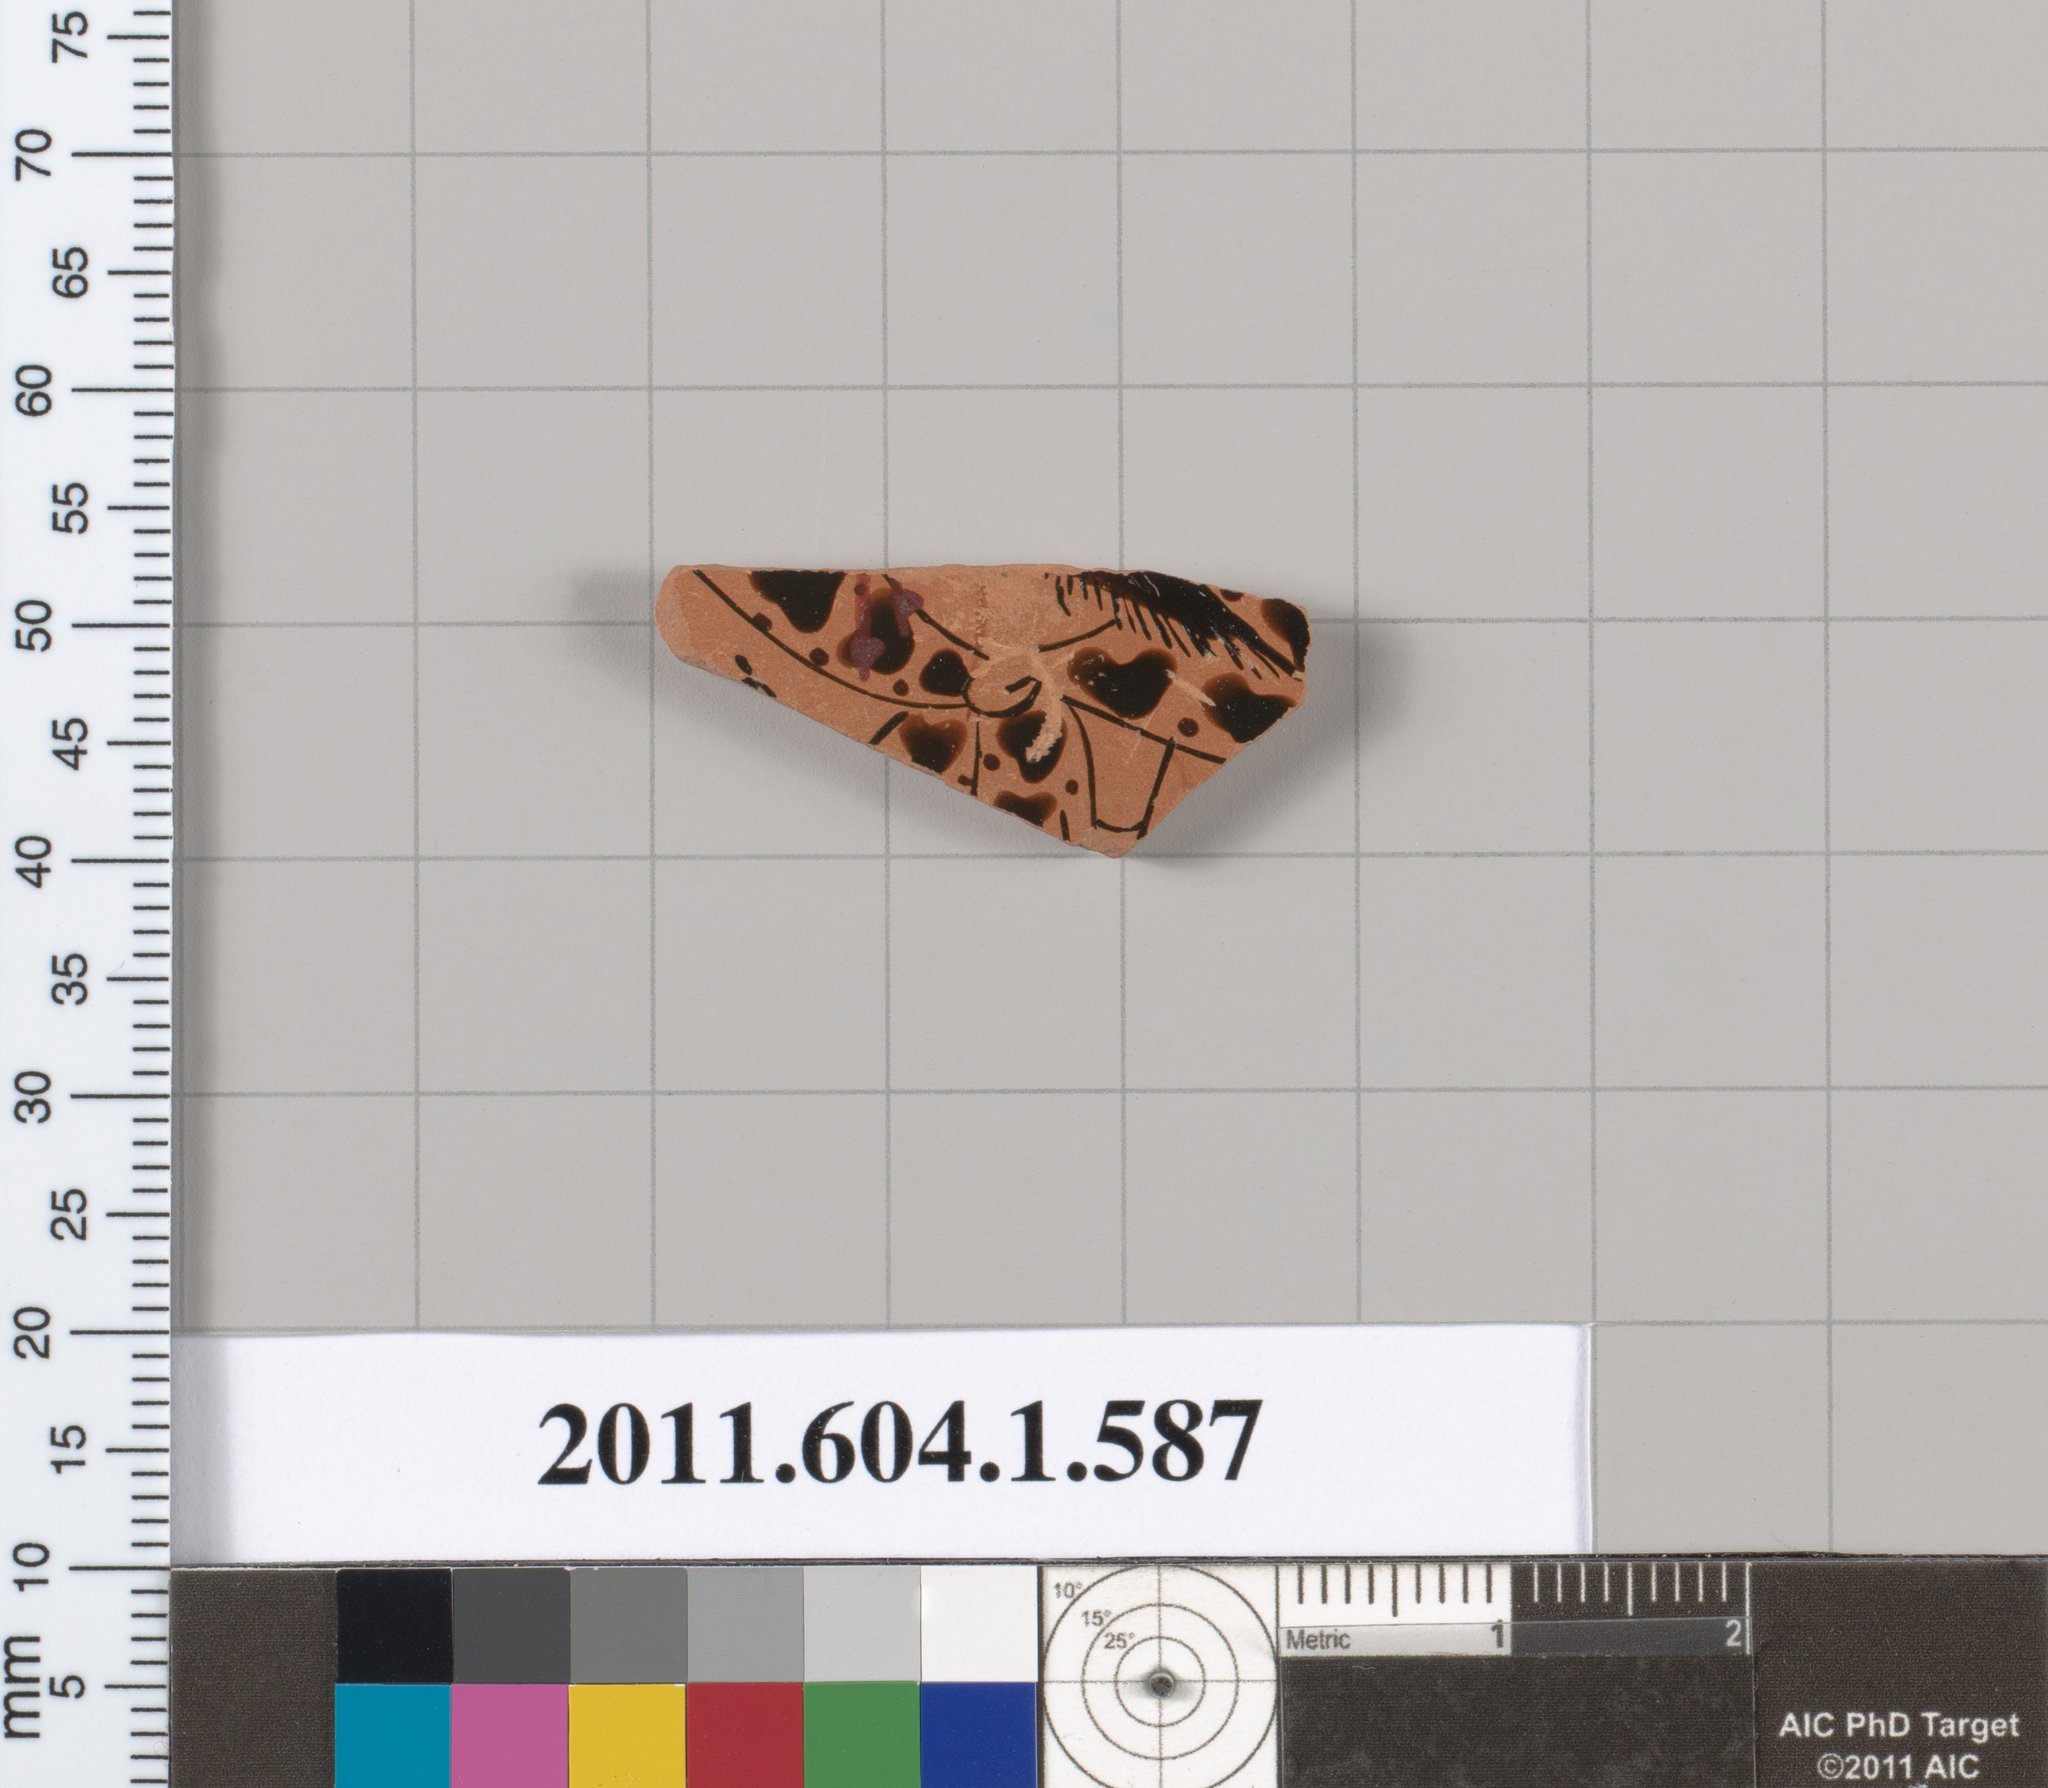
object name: kylix fragment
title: Terracotta fragment of a kylix (drinking cup)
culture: greek, attic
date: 475-451 BCE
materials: terracotta